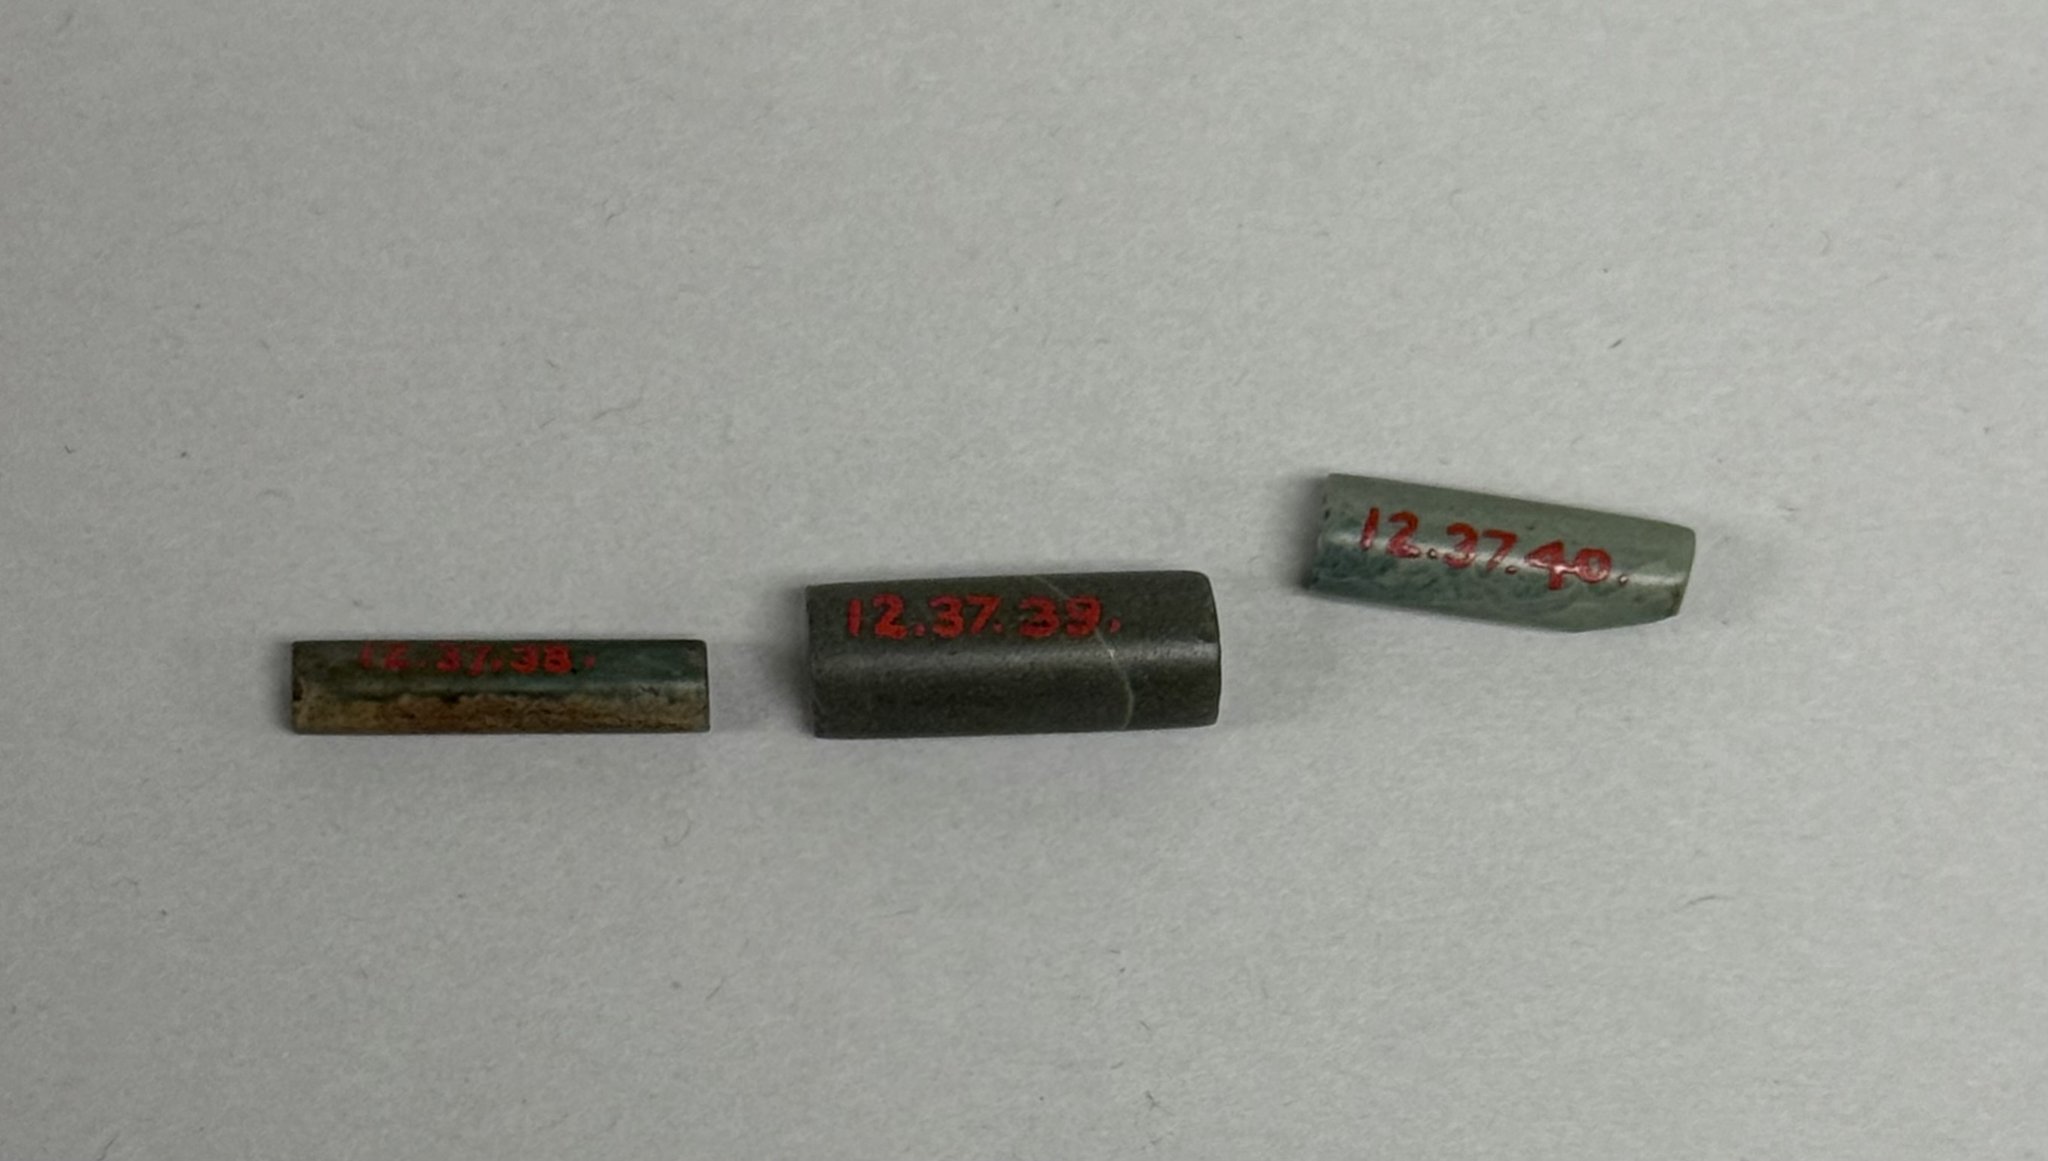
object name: cylinder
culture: japanese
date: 601-700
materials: jasper